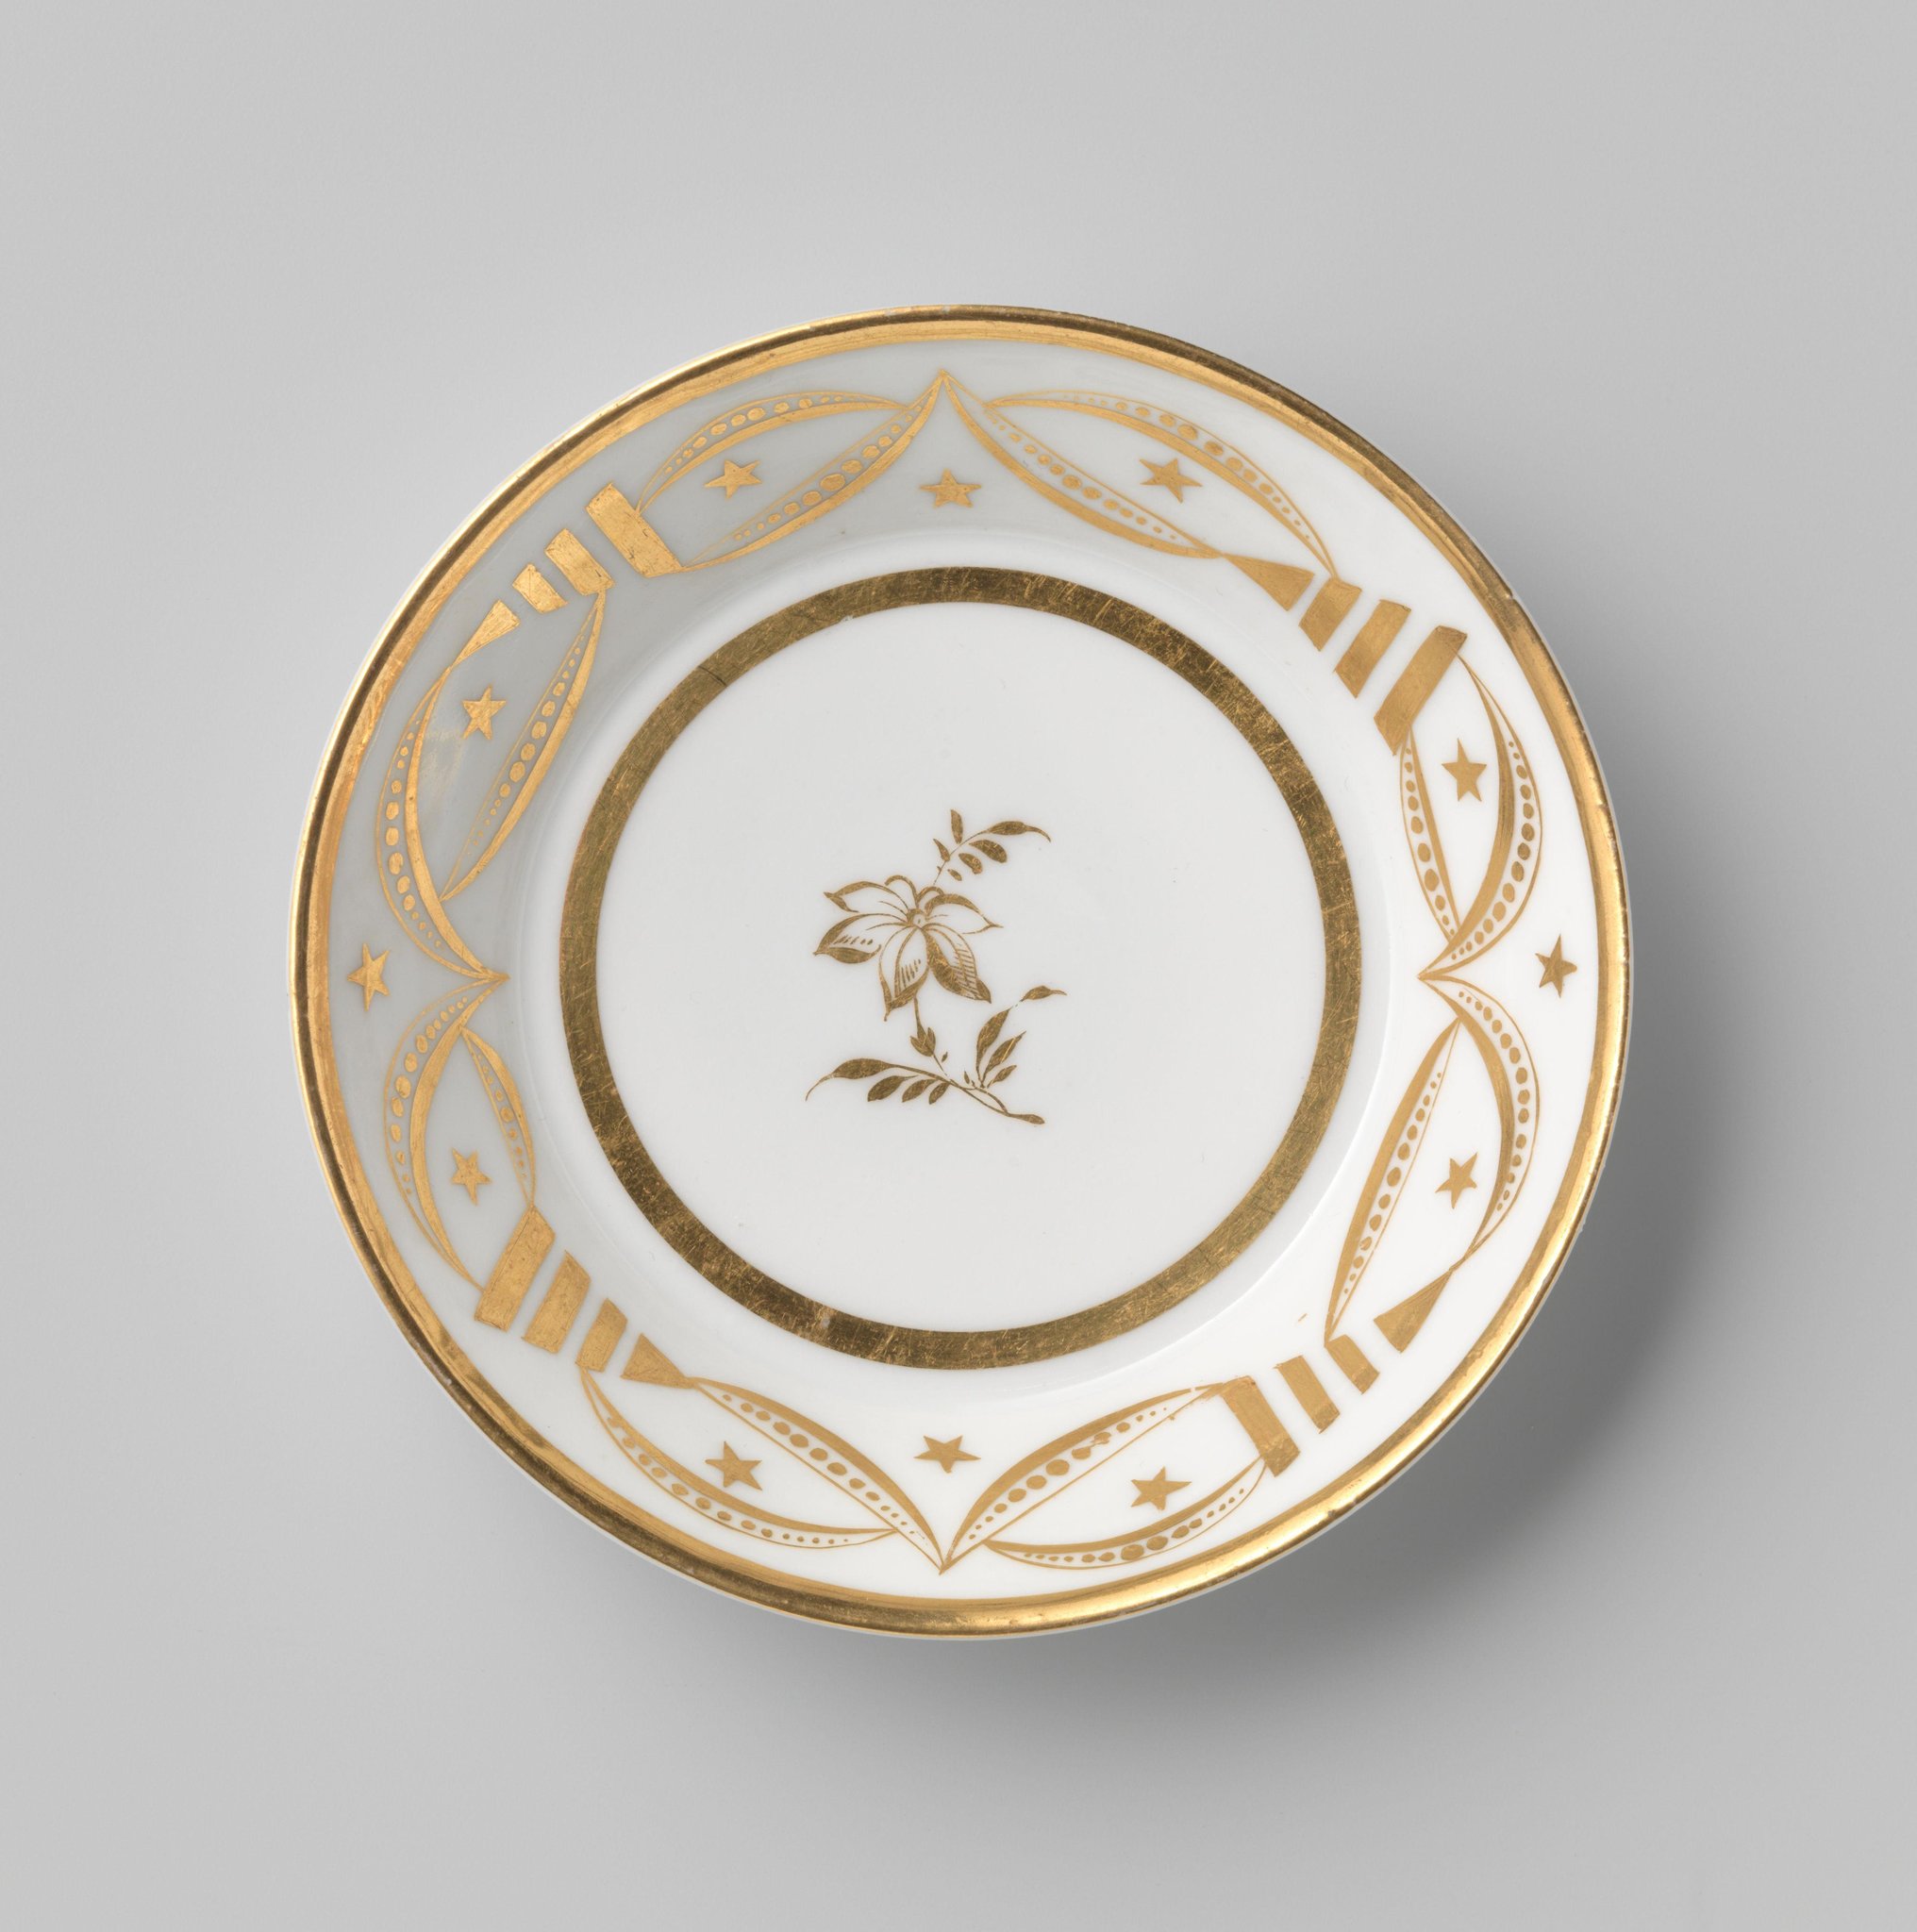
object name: platter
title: Saucer with a flower spray and ornamental border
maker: Anonymous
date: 1800-1824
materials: glaze, gold, paint, porcelain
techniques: firing, forming, gilding, turning, vitrification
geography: france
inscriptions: mark: ‘g’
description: Schotel van porselein, versierd met gouden banden waartussen een slingermotief dat wordt gevormd door halvemaanvormige schijven waarin punten. De schijven worden verbonden door driehoeken. Op de tussenliggende velden gouden sterren. Op het plat een bloemtak. Behoort tot een serie van twaalf kop-en-schotels (BK-16044-F-1-24), onderdeel van een koffie- en theeservies.